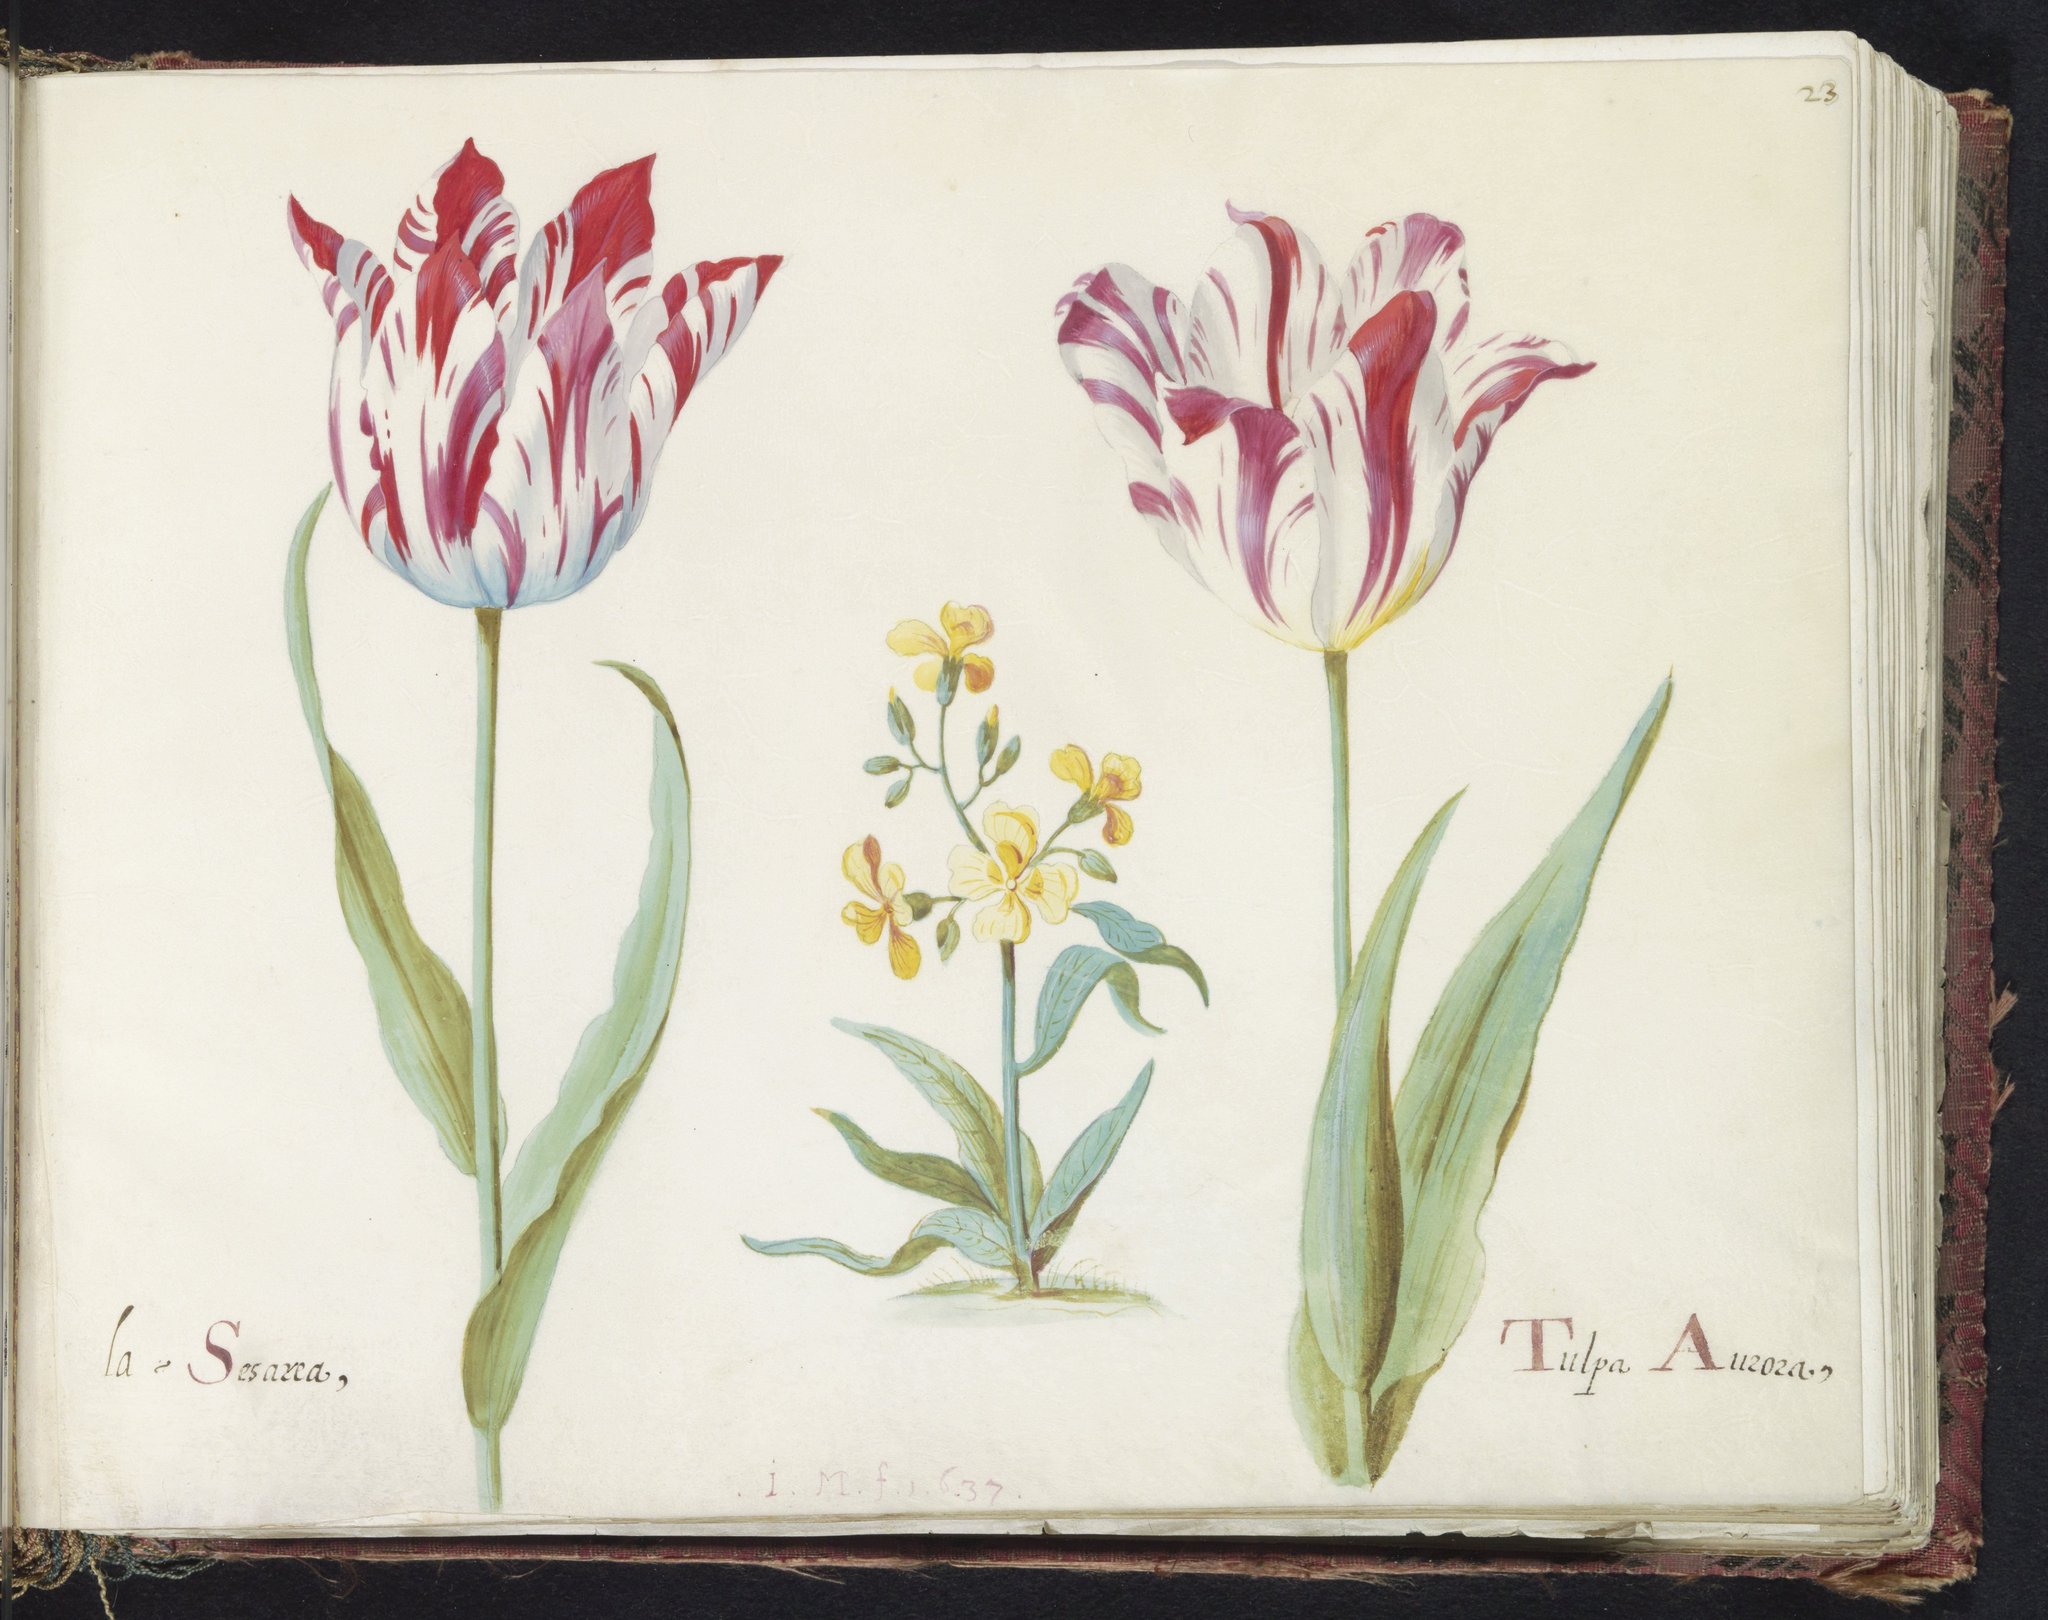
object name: drawing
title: Twee tulpen met plant uit de kruisbloemenfamilie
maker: jacob marrel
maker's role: draughtsman, painter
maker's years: 1614-1681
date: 1637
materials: paint, parchment, pencil, watercolor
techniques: brush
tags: flowers: tulip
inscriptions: date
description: De tekening maakt deel uit van een album.